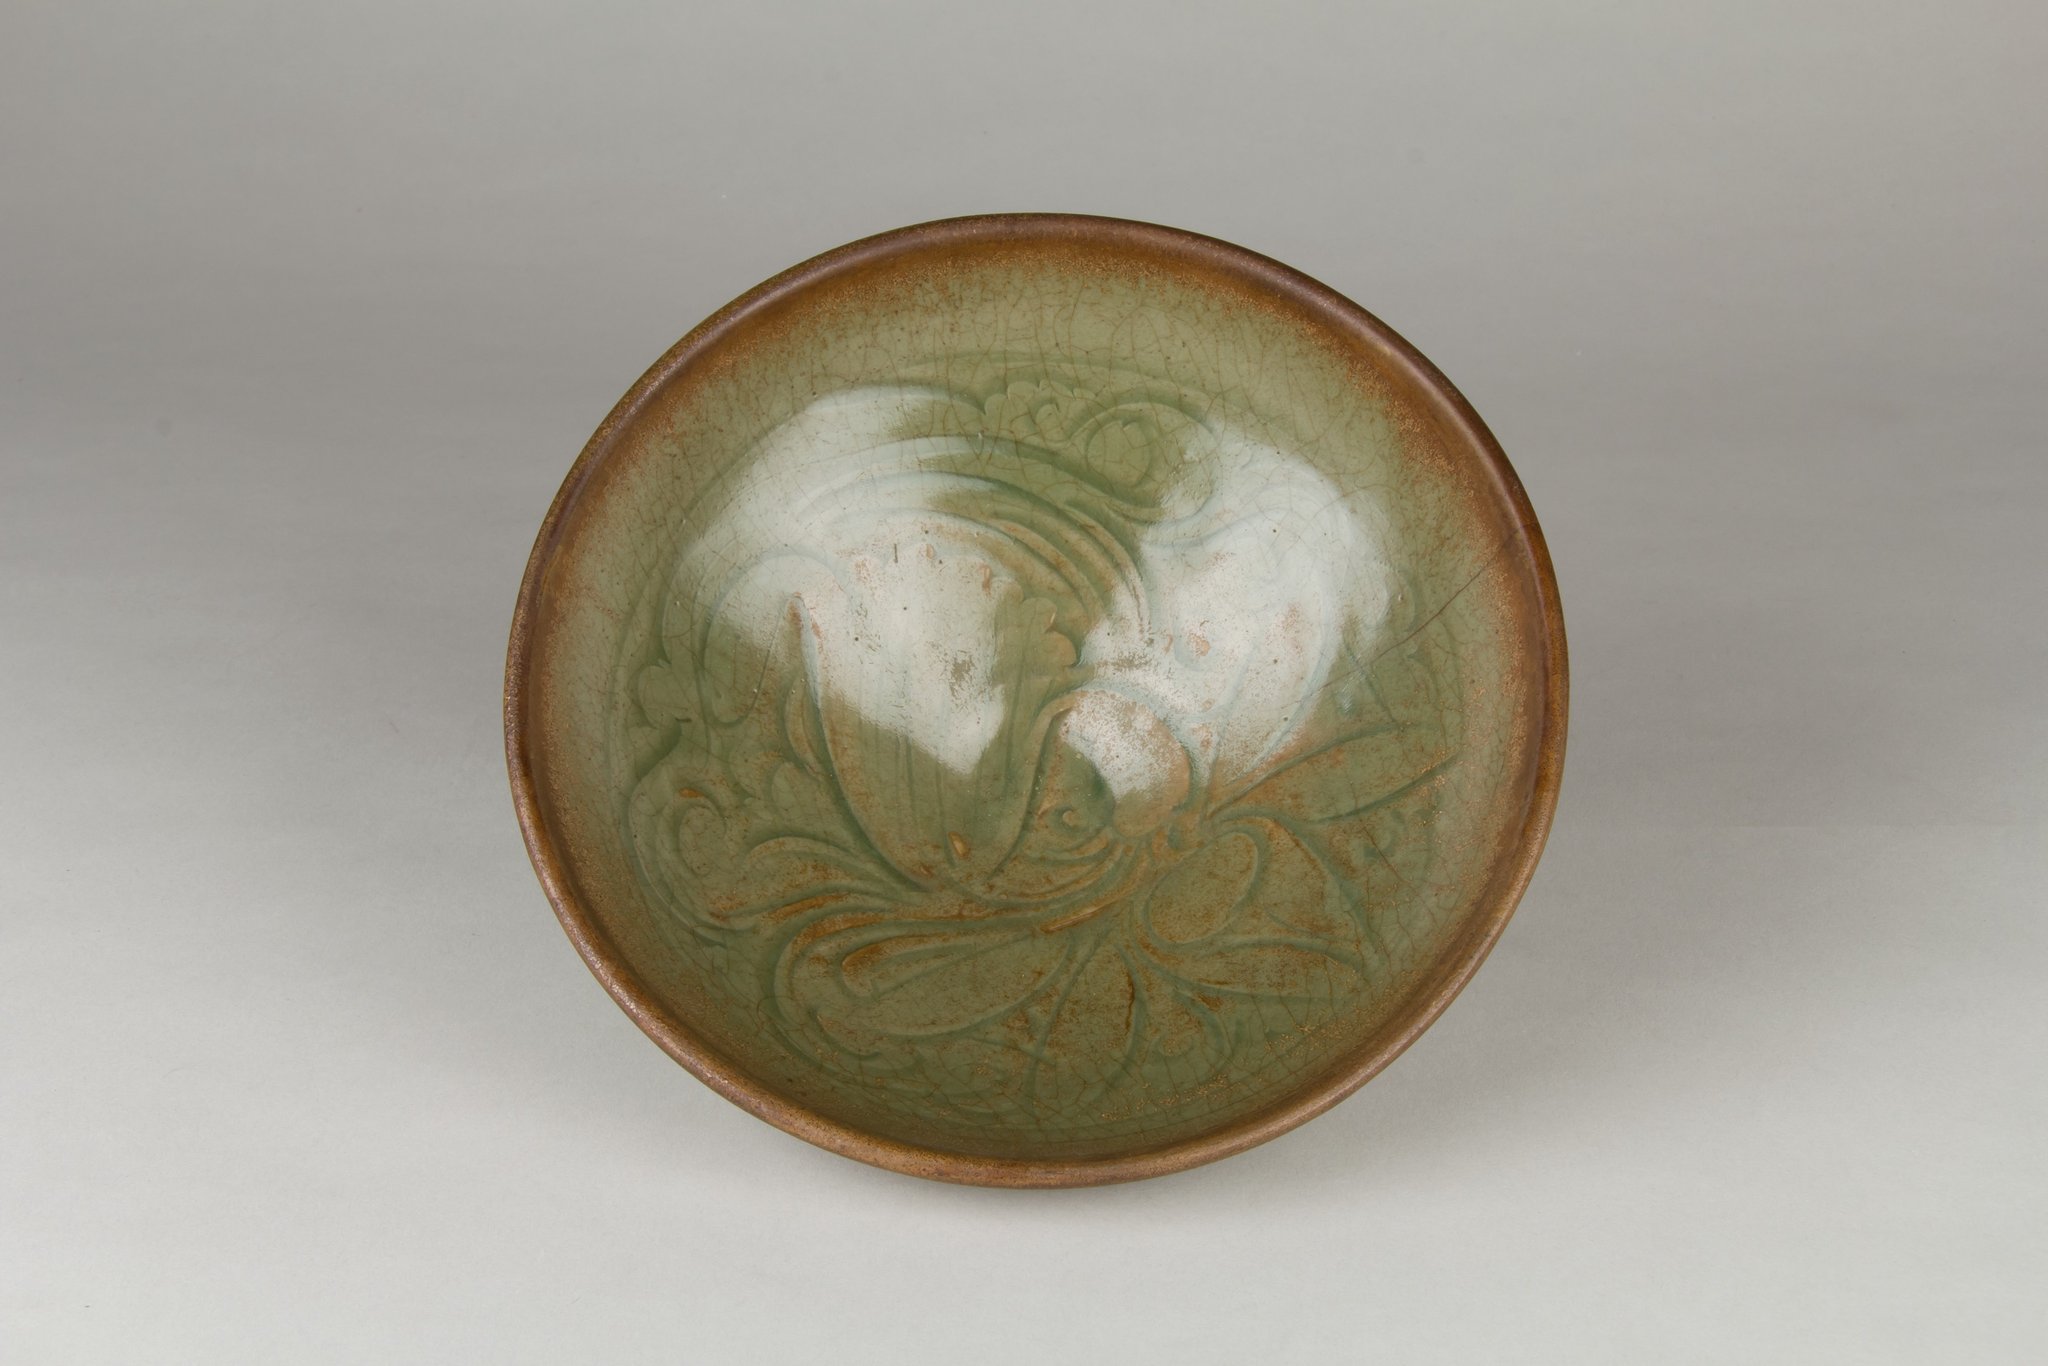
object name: bowl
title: Bowl with lotus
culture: chinese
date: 1001-1200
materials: ceramic glaze, glaze, stoneware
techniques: incising